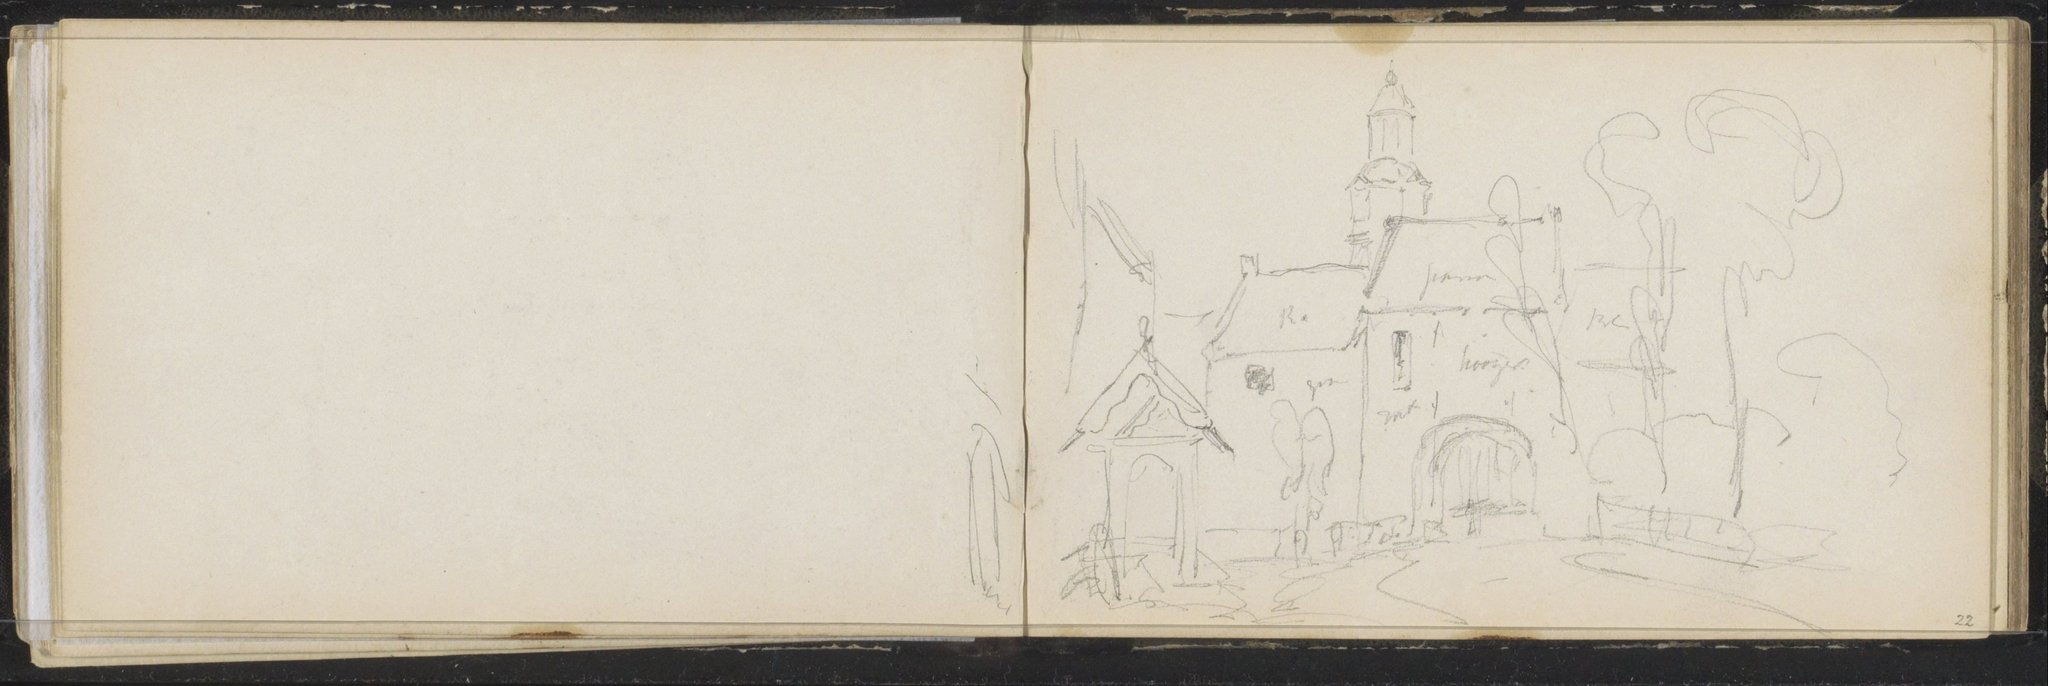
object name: sketchbook leaf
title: Gezicht op Buren met de Sint-Lambertuskerk en de Huizenpoort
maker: cornelis springer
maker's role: draughtsman, painter, print maker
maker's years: 1817-1891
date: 1863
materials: paper, pencil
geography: buren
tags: city-view, and landscape with man-made constructions, church (exterior), city-gate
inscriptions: kleurnotitie, handgeschreven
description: Gezicht op Buren met de Sint-Lambertuskerk en de Huizenpoort. Blad 21 verso en blad 22 recto uit een schetsboek met 55 bladen vervaardigd op de Veluwe en in Noord-Duitsland.